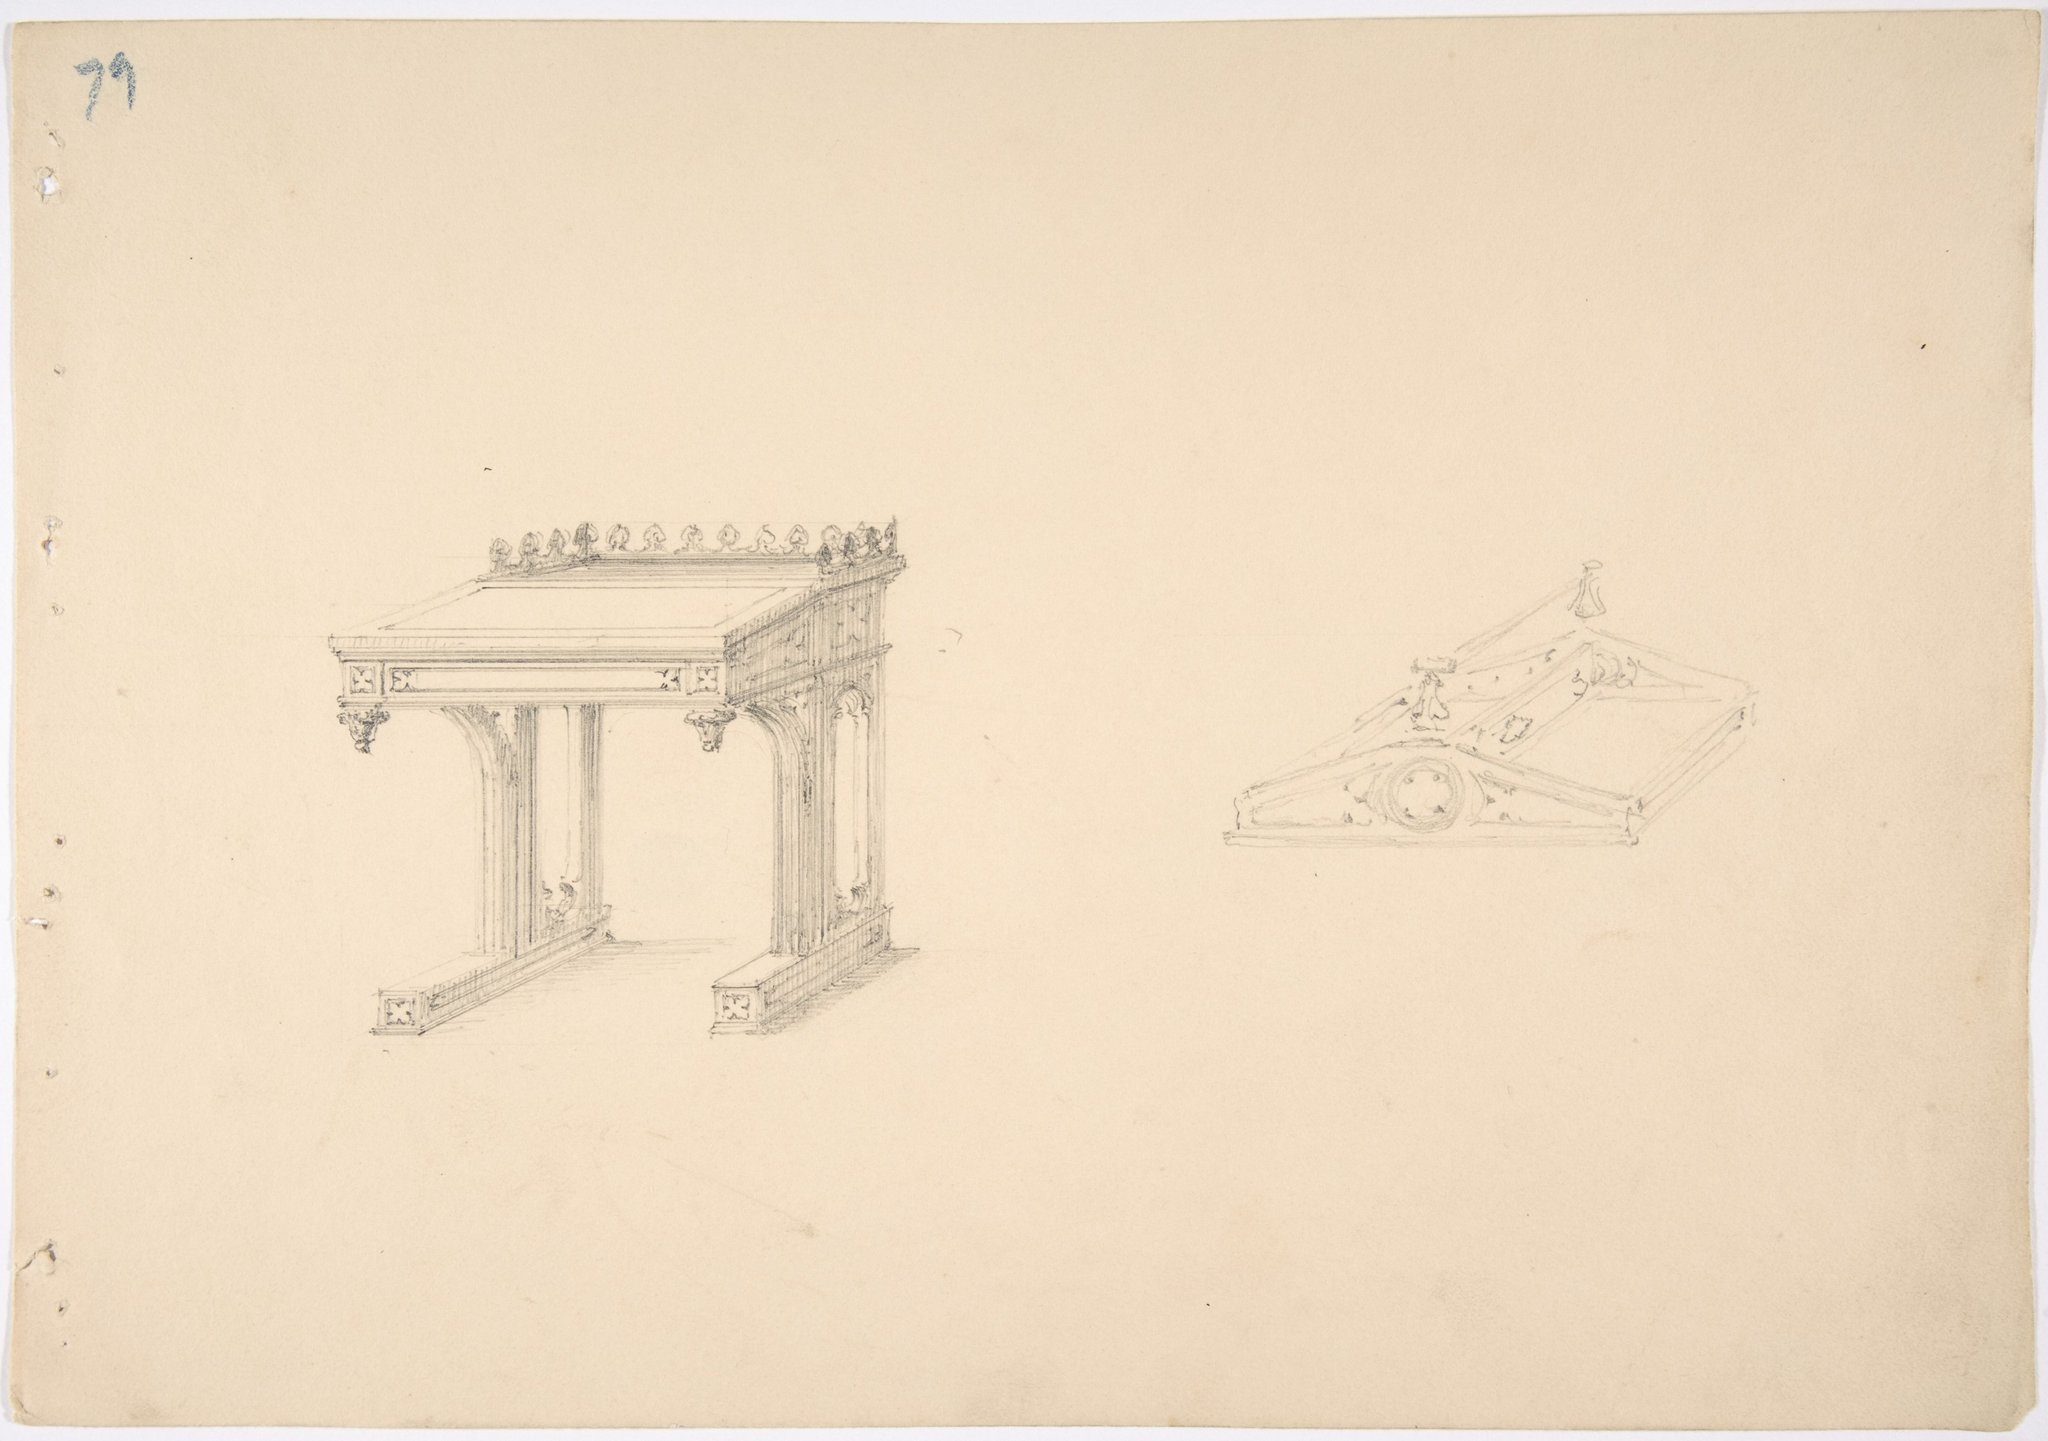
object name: drawing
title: Design for a Gothic Desk and Tray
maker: anonymous, british, 19th century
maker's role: artist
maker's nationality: british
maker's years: 1800-1900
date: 1801-1833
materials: graphite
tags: desks,trays